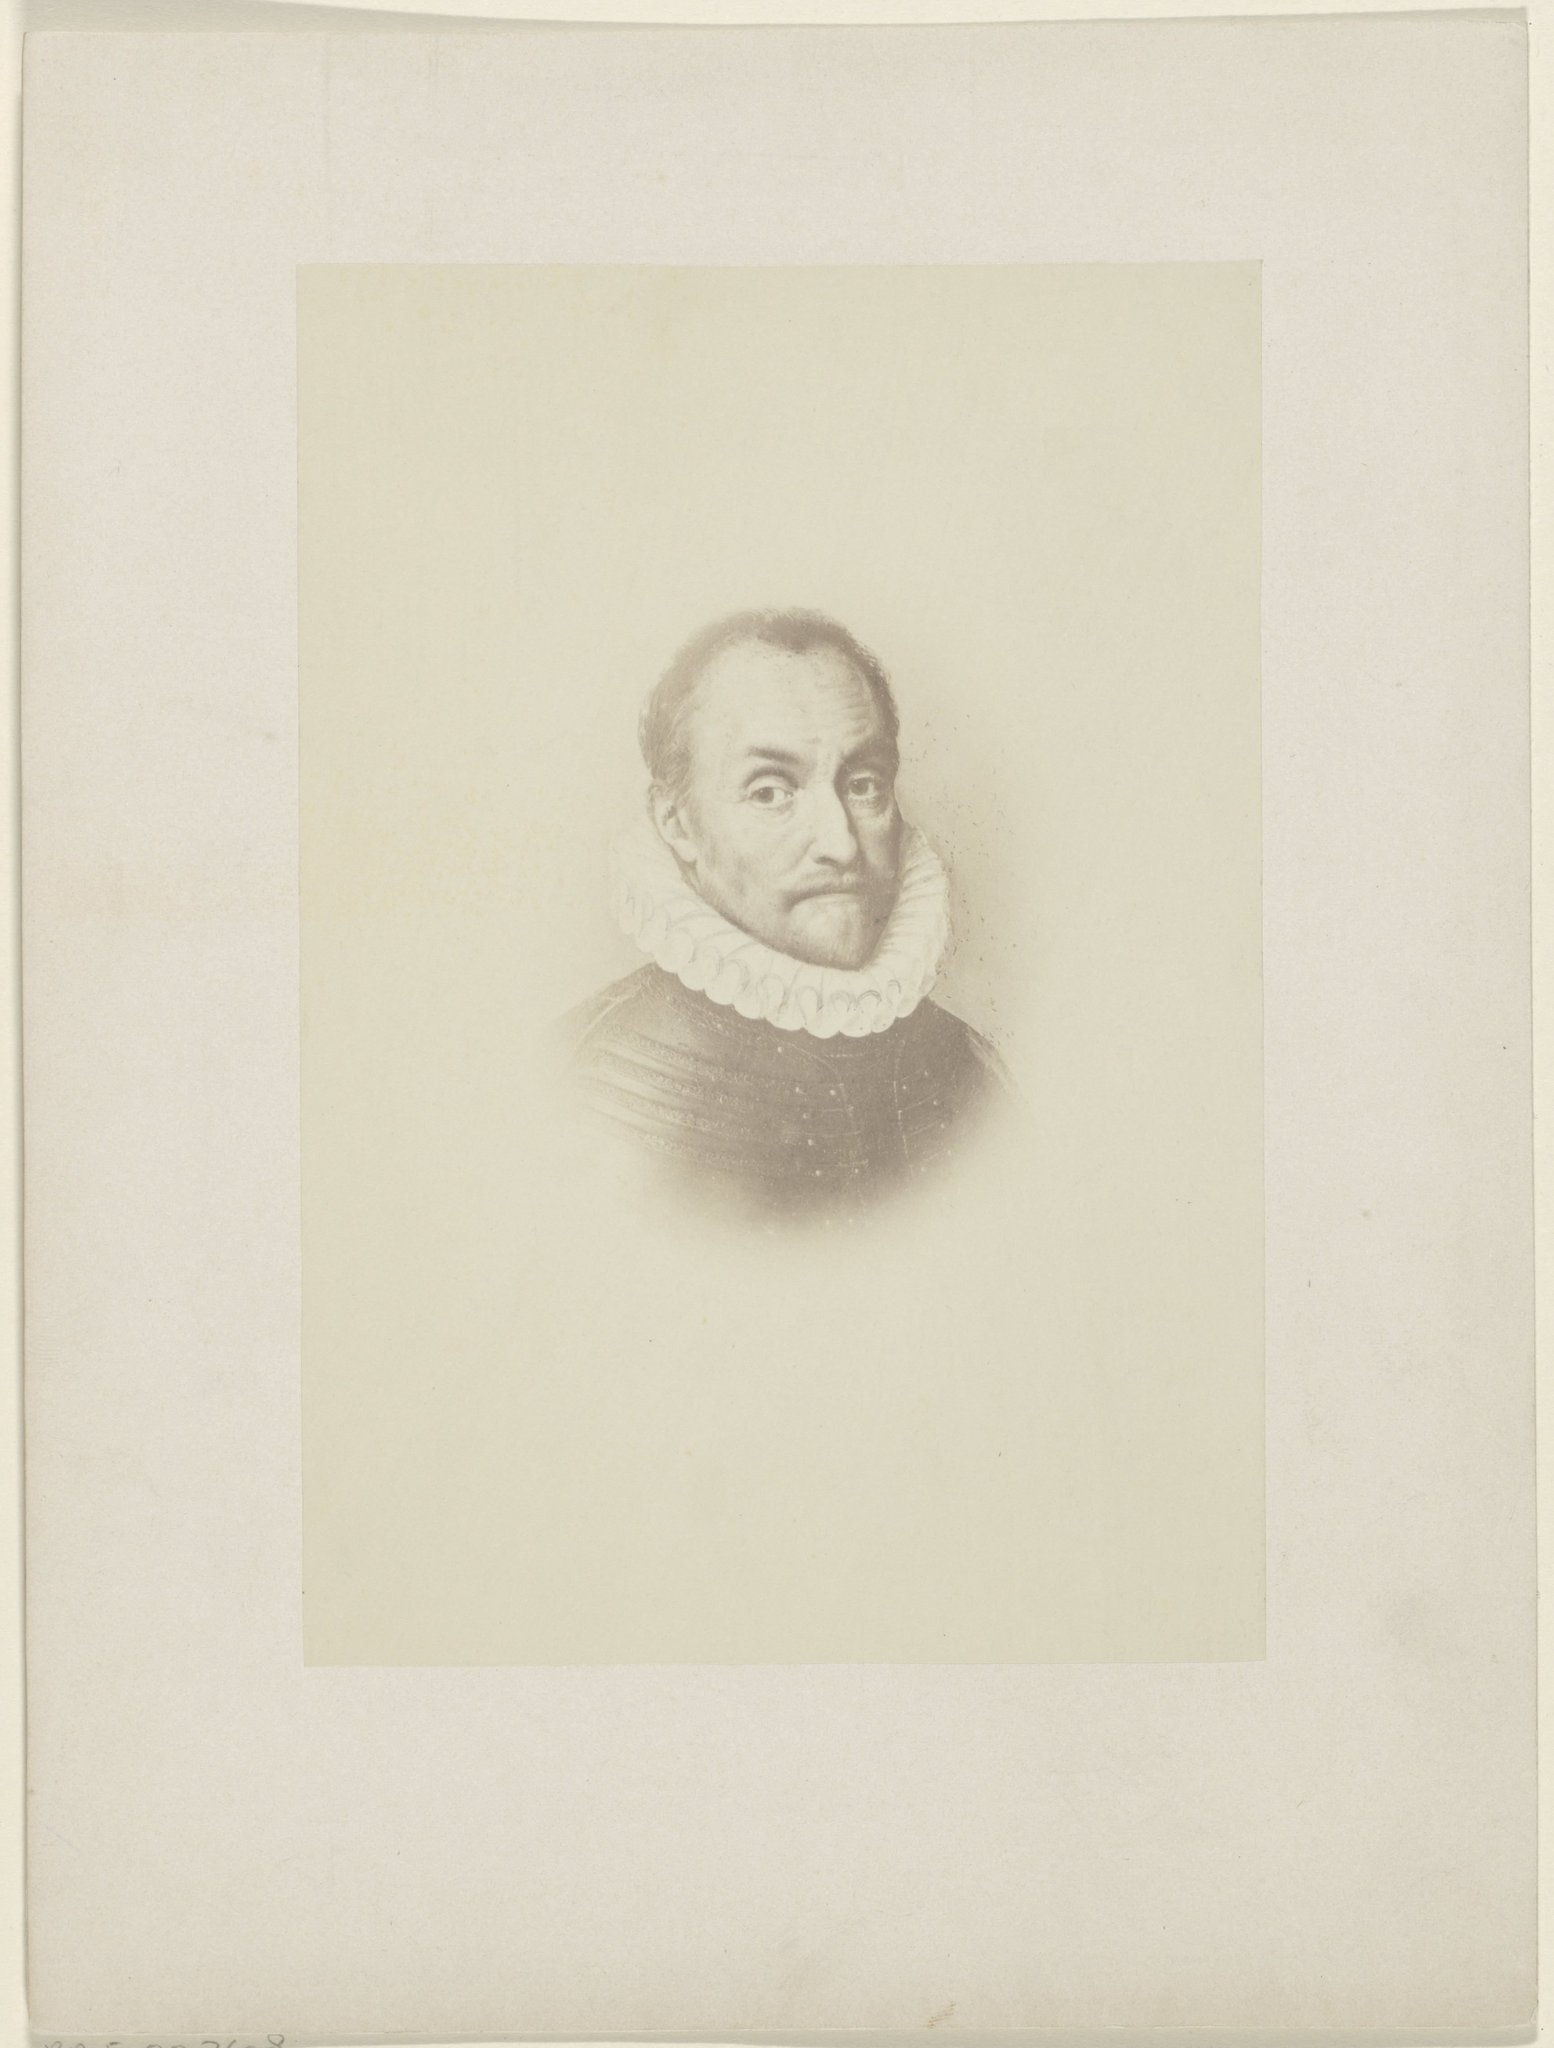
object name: photograph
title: Portret van Willem I, prins van Oranje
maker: Anonymous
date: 1850-1930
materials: photographic support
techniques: photography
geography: netherlands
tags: william i (prince of orange)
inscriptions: collector's mark: Lugt 1097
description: De hier vermelde titel verwijst naar de hoogst verkregen titel van de geportretteerde, niet per se naar de titel die de geportretteerde op deze voorstelling draagt.